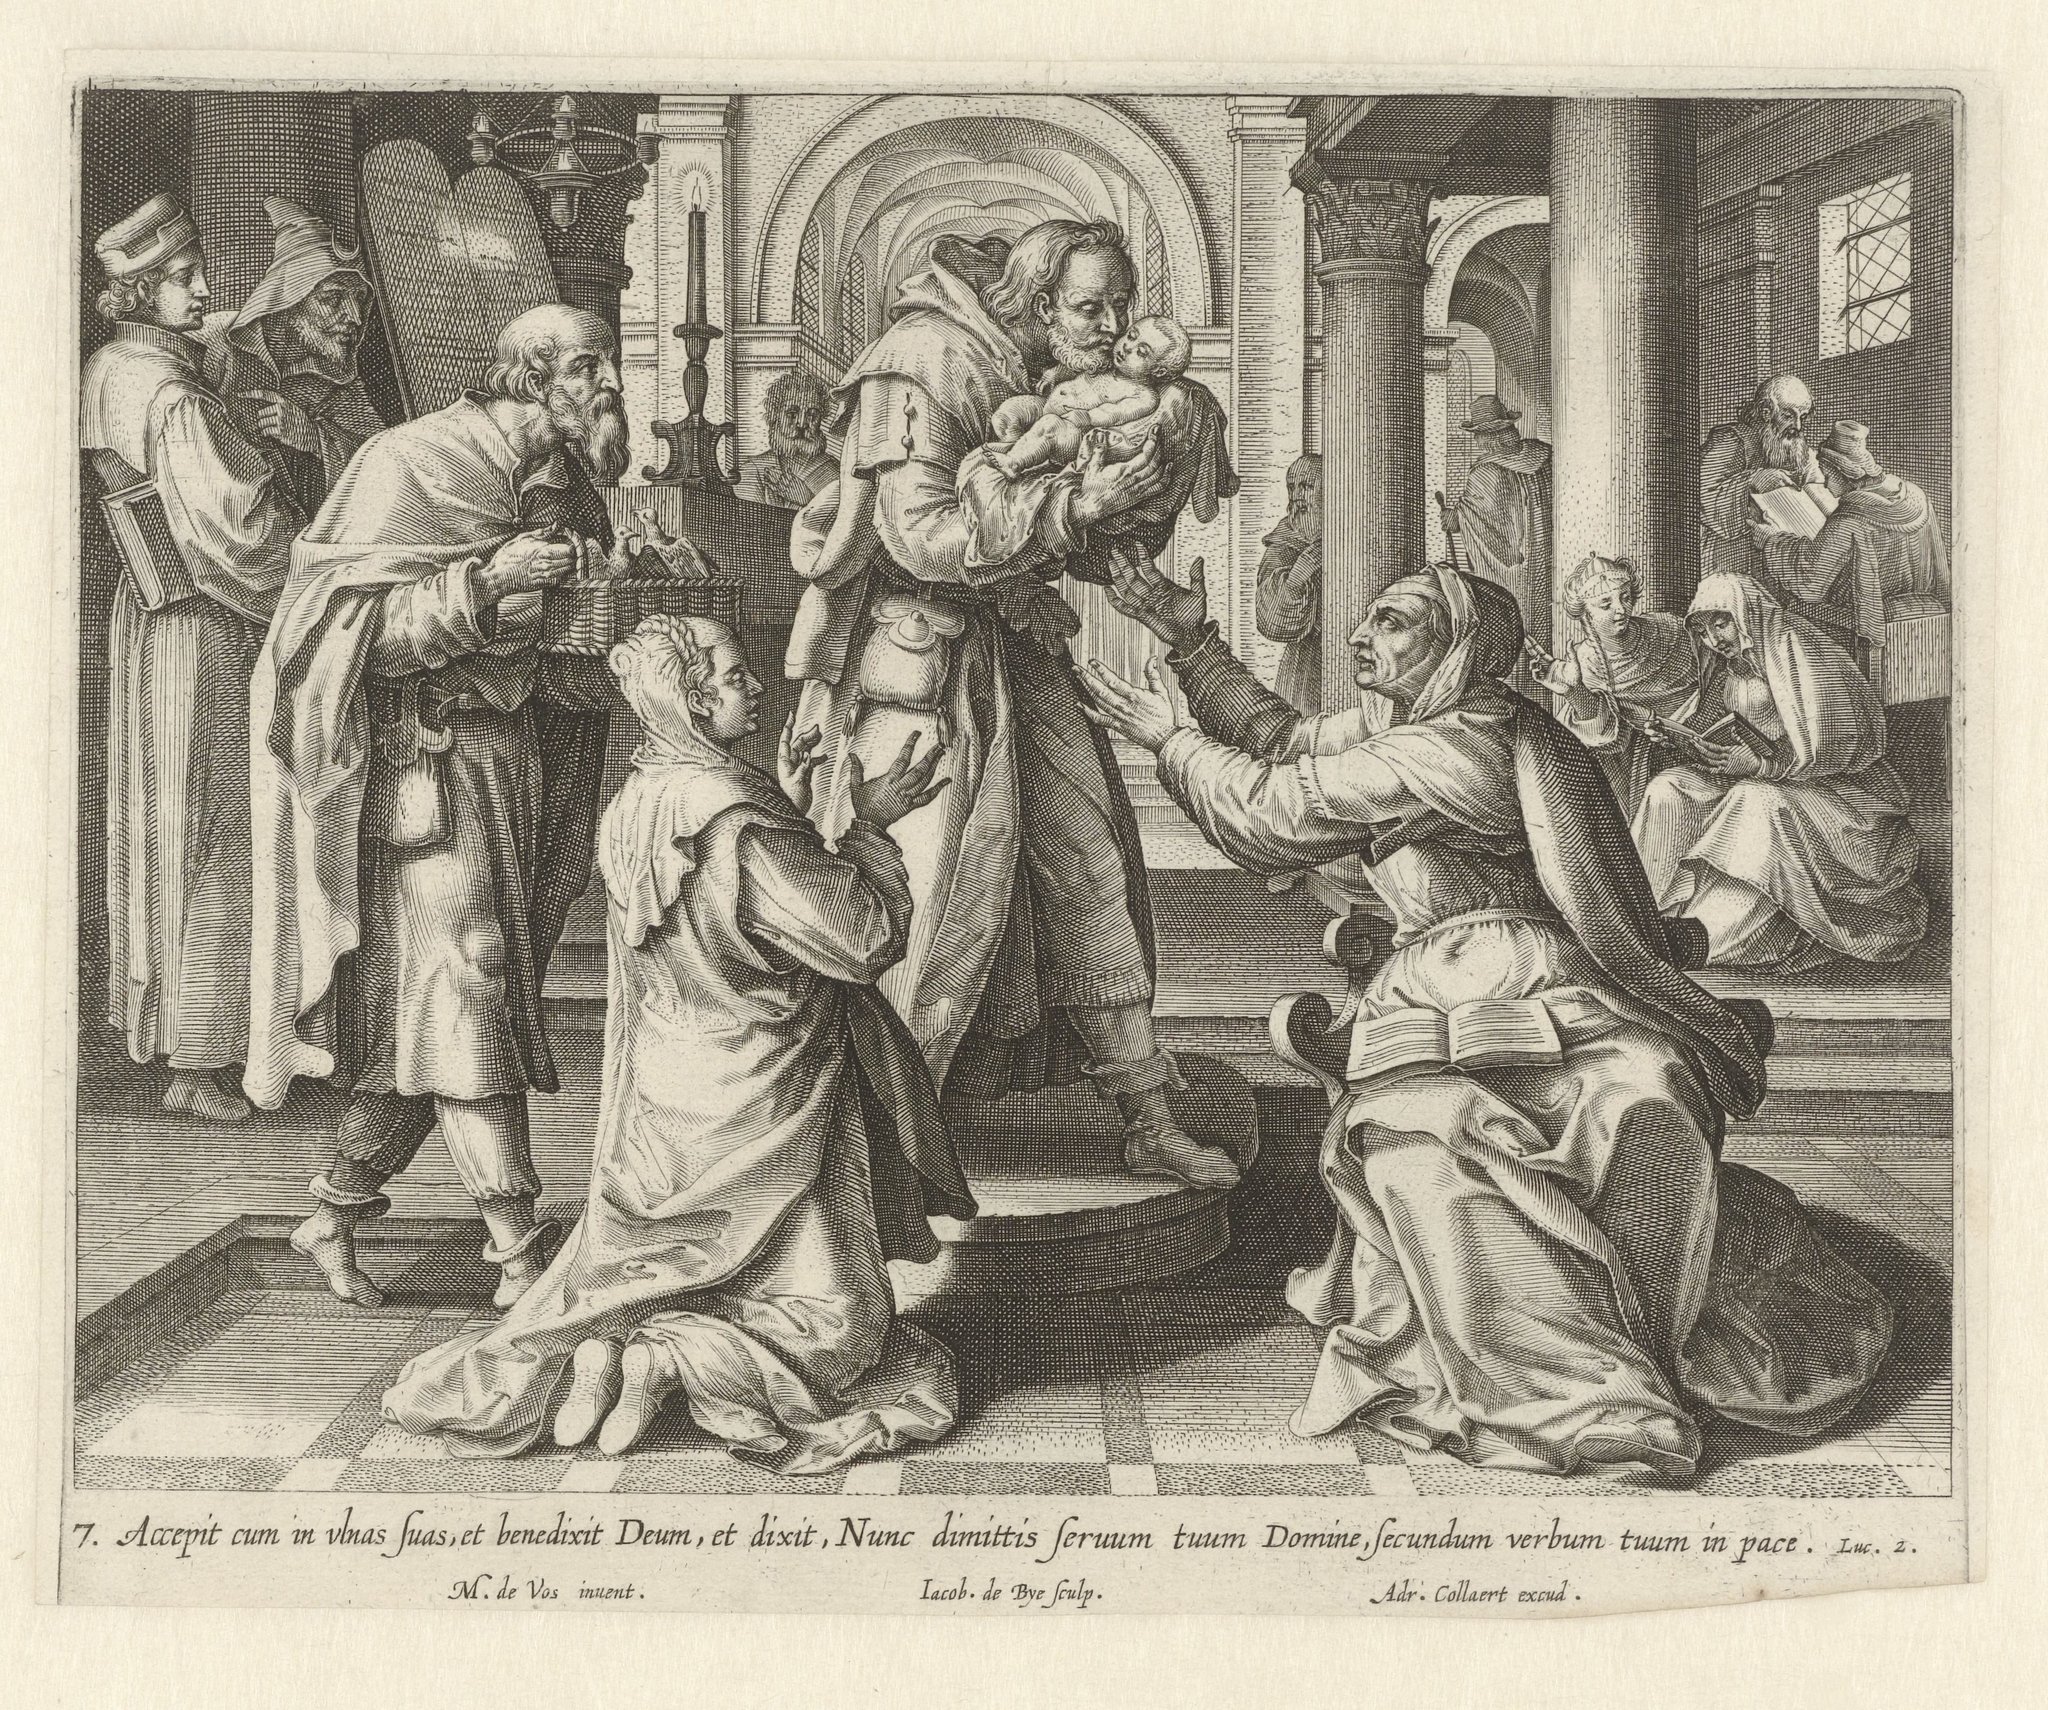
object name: print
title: Leven, passie en wederopstanding van Christus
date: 1598-1618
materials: paper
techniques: engraving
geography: antwerp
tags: simeon, holding the christ-child, sings his canticle: 'nunc dimittis'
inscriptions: collector's mark: Lugt 2228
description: Het interieur van een tempel. Centraal Simeon die het Christuskind kust. De profetes Hanna zit naast hem. Maria knielt voor Simeon. Jozef staat naast hem en heeft een mandje met twee duifjes in zijn handen die als offer dienen (Lucas 2:22-39). De prent heeft een Latijns onderschrift. De prent maakt deel uit van een serie over het leven van Christus.